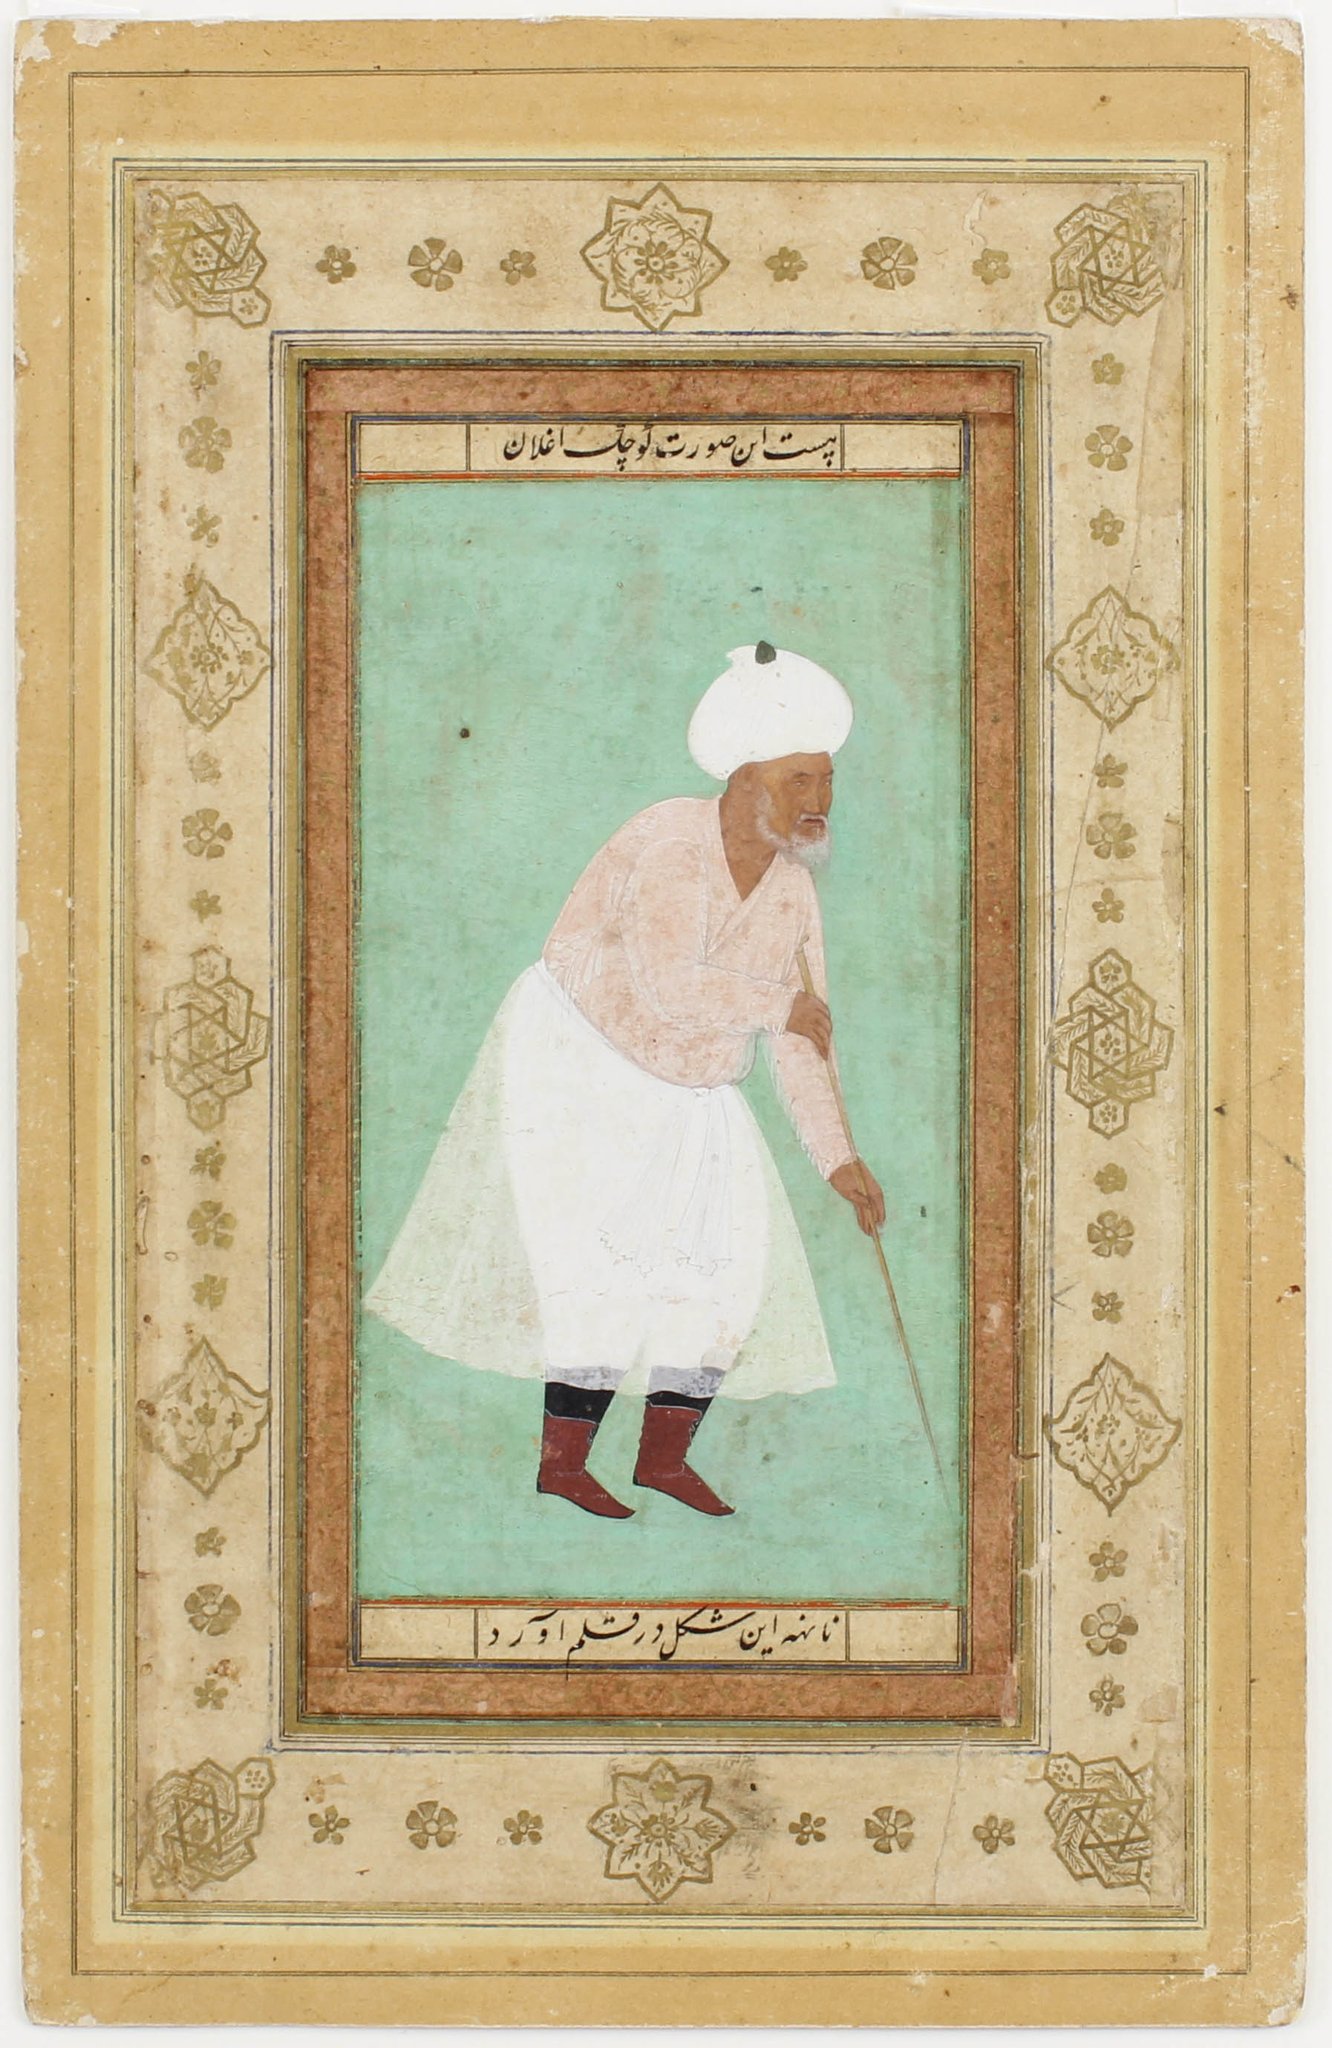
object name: illustrated album leaf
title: Portrait of Kuchal Oghlan: Folio from Salim's Album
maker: nanha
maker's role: artist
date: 1595-1600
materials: gold, paper, watercolor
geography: india